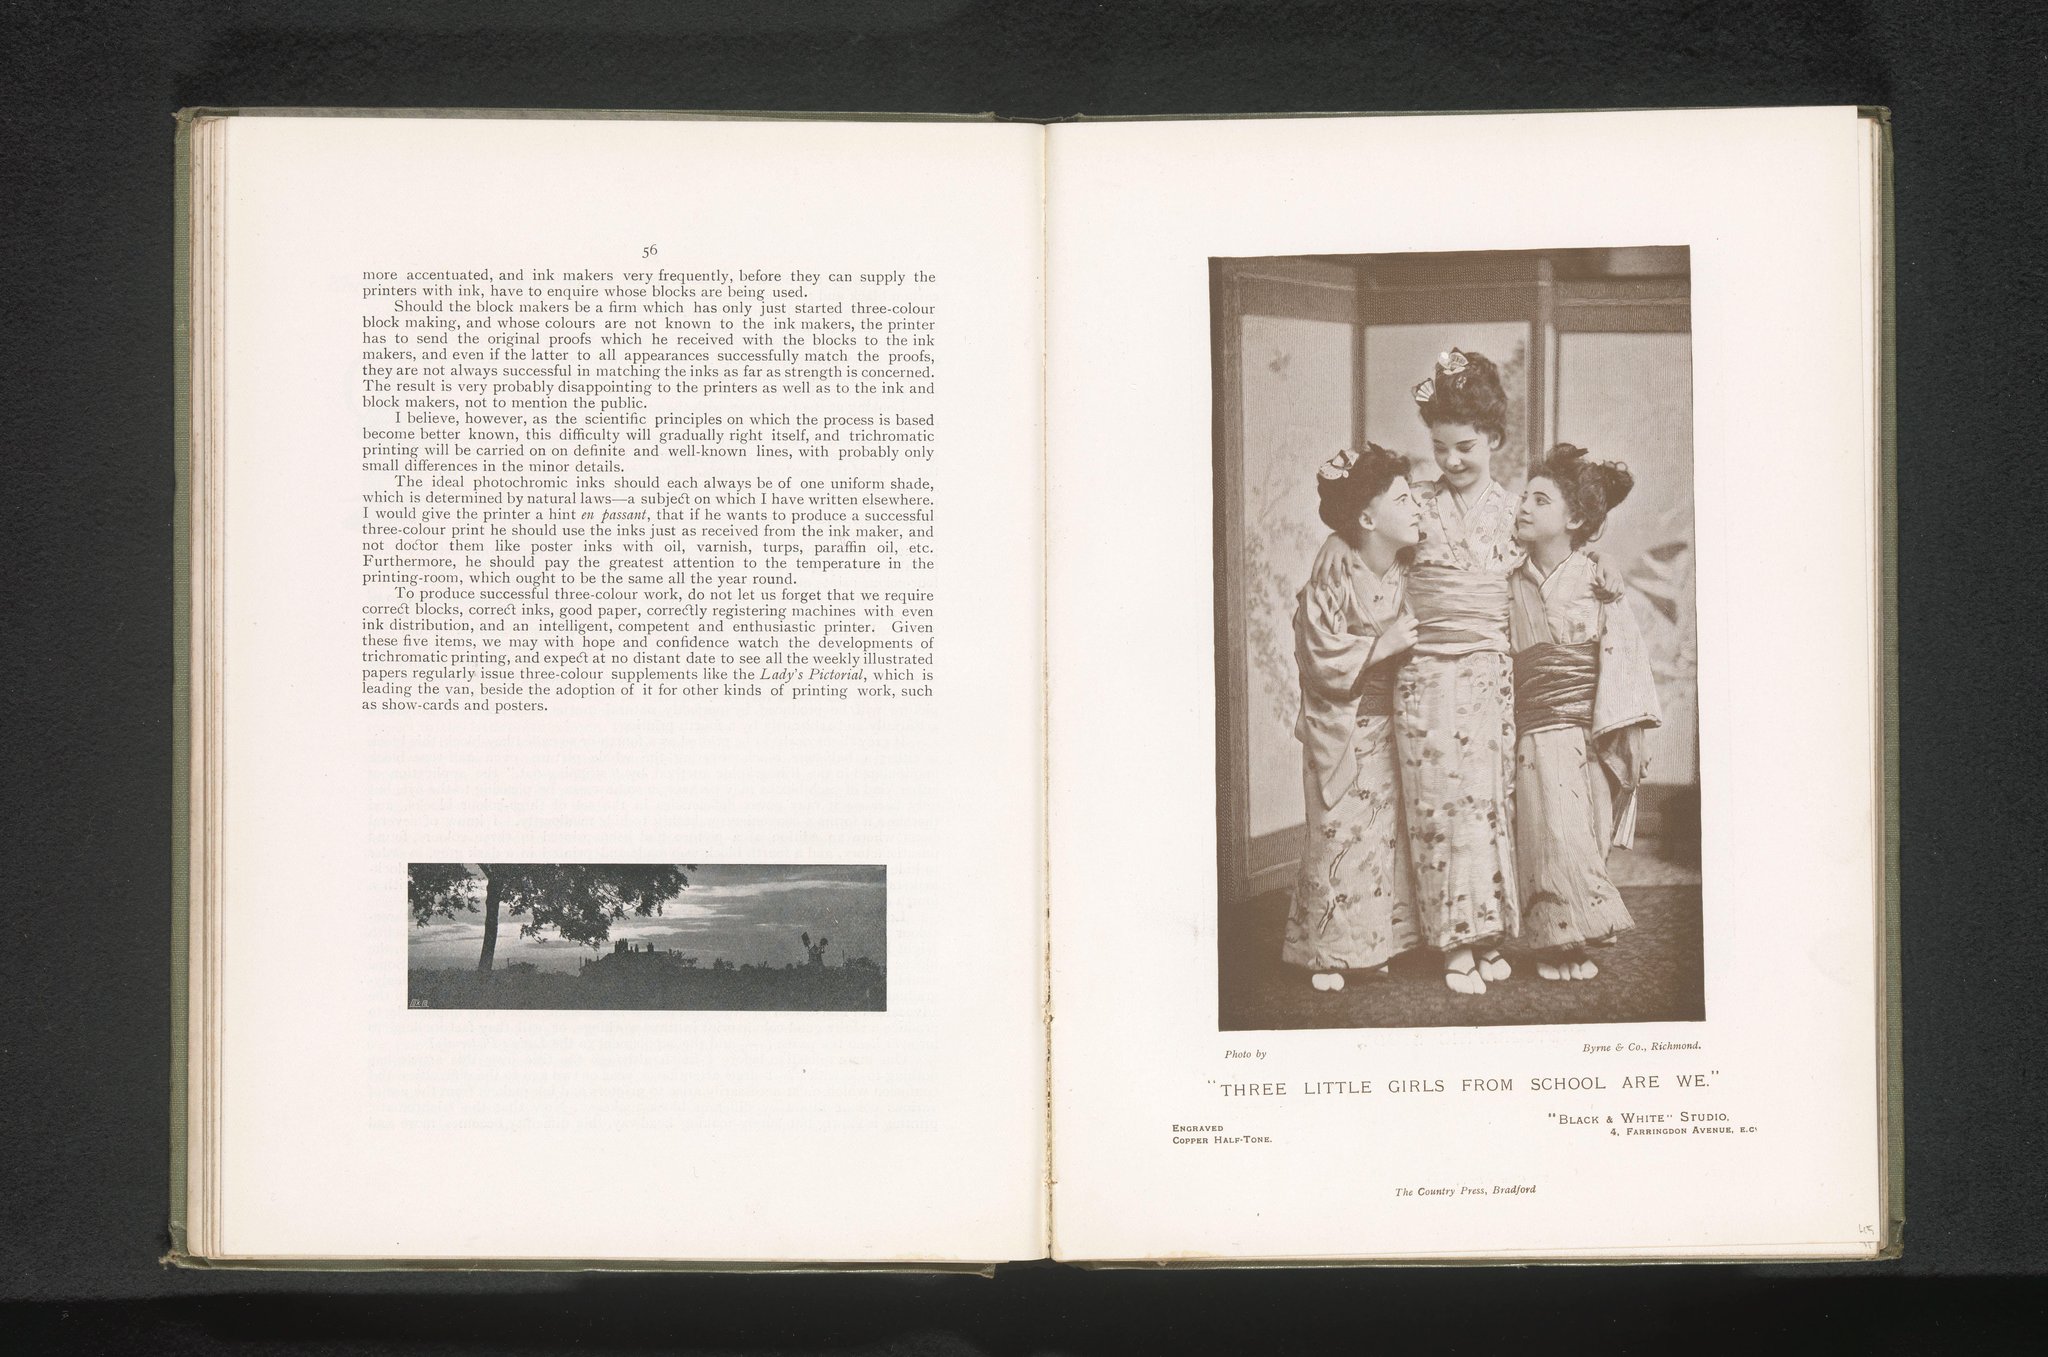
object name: page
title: Drie meisjes in kimono's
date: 1893-1898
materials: paper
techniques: autotype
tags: girl (child between toddler and youth), anonymous historical persons portrayed in a group, in a group-portrait